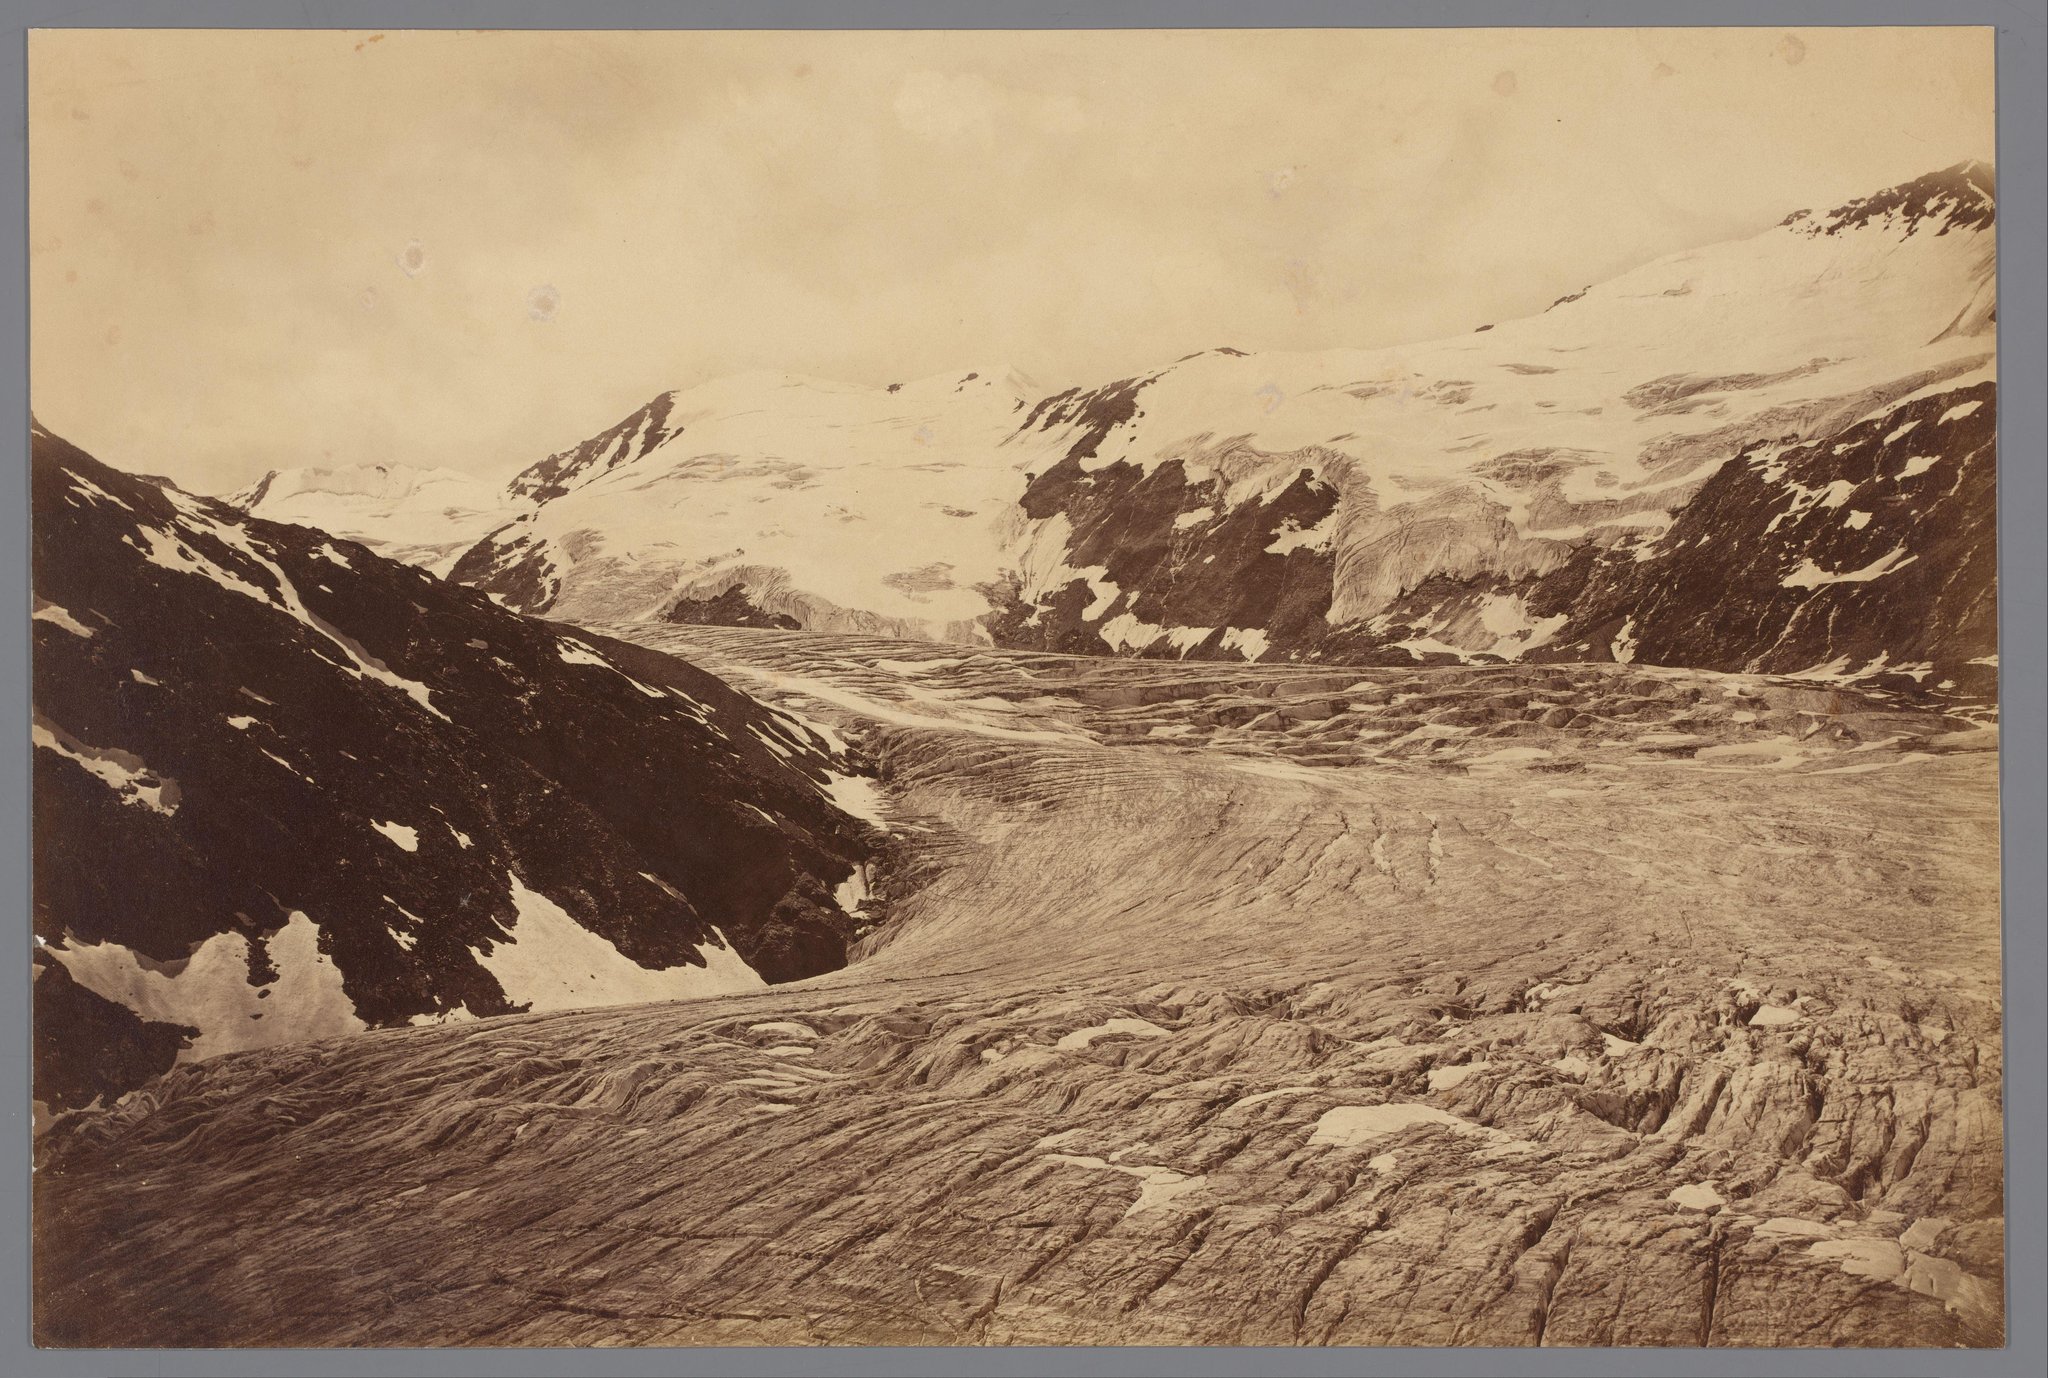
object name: photograph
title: Bergketen [Alpen?] in Oostenrijk, Italië, Zwitserland of Duitsland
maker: Anonymous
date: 1880-1900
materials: cardboard, paper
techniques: albumen print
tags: europe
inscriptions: number: ‘1405.’, inscription: ‘1860-70’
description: Bergketen [Alpen?] in Oostenrijk, Italië, Zwitserland of Duitsland.